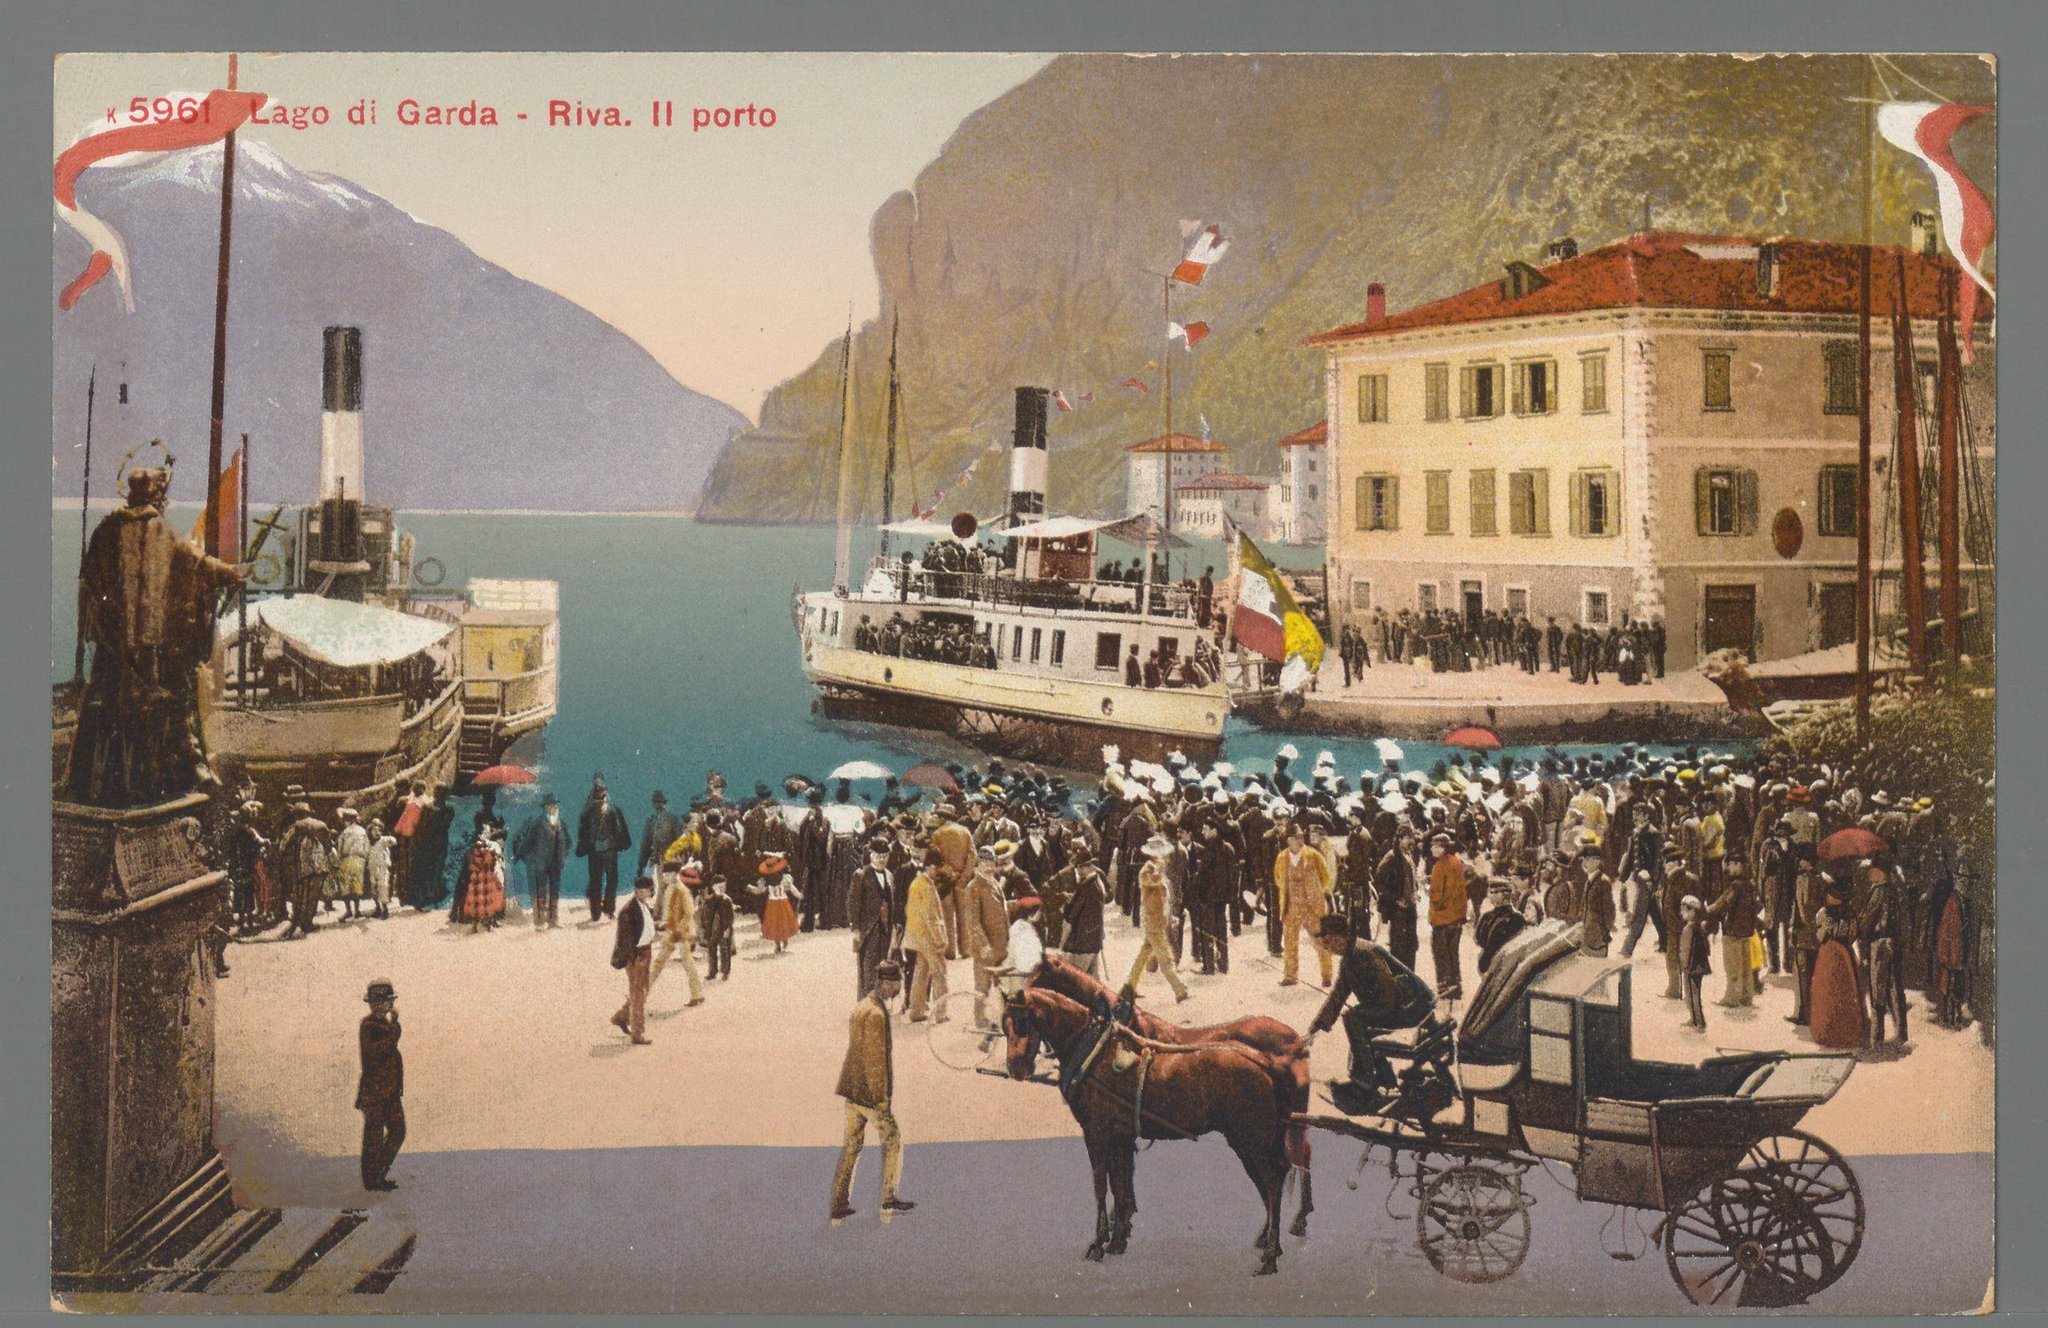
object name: photomechanical print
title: Lago di Garda. Riva. Il porto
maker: Anonymous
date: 1905-1930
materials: cardboard, photographic process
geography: zurich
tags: harbour, crowd, mob, lake